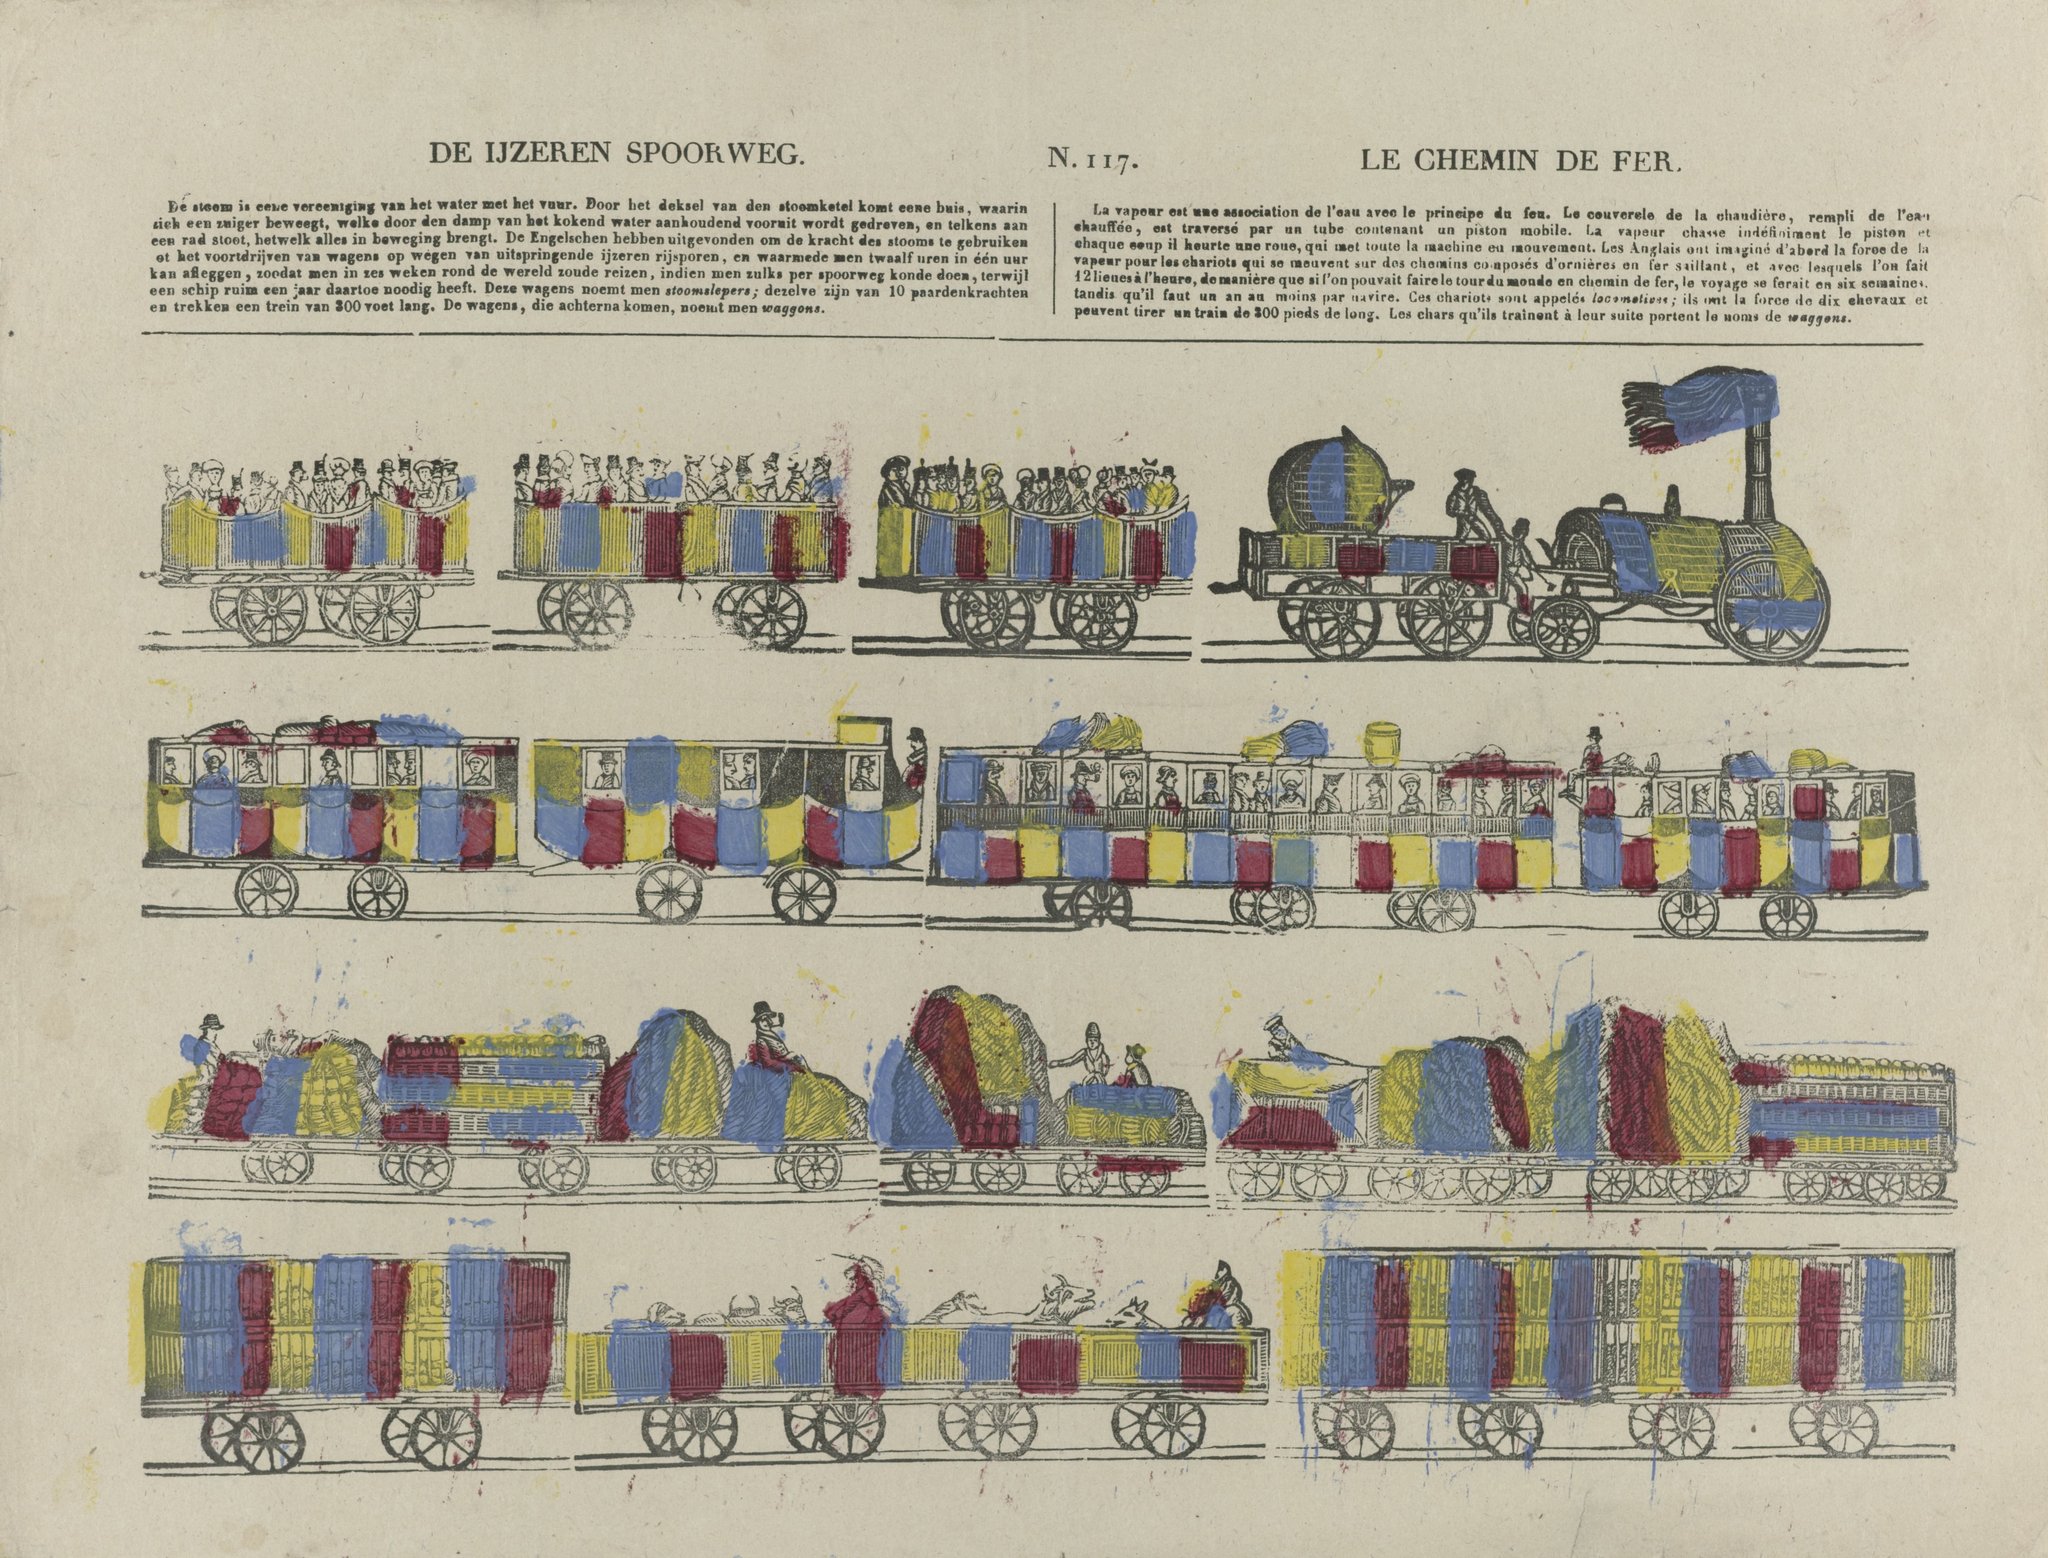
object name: print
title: De ijzeren spoorweg / Le chemin de fer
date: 1800-1833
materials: paper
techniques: colour, letterpress printing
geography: turnhout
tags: passenger train, railway, train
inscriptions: collector's mark: Lugt 2760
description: Blad met 4 horizontale rijen met voorstellingen van een trein. Een zevenregelig bovenschrift in het Nederlands en in het Frans in twee kolommen. Genummerd midden boven: N. 117.